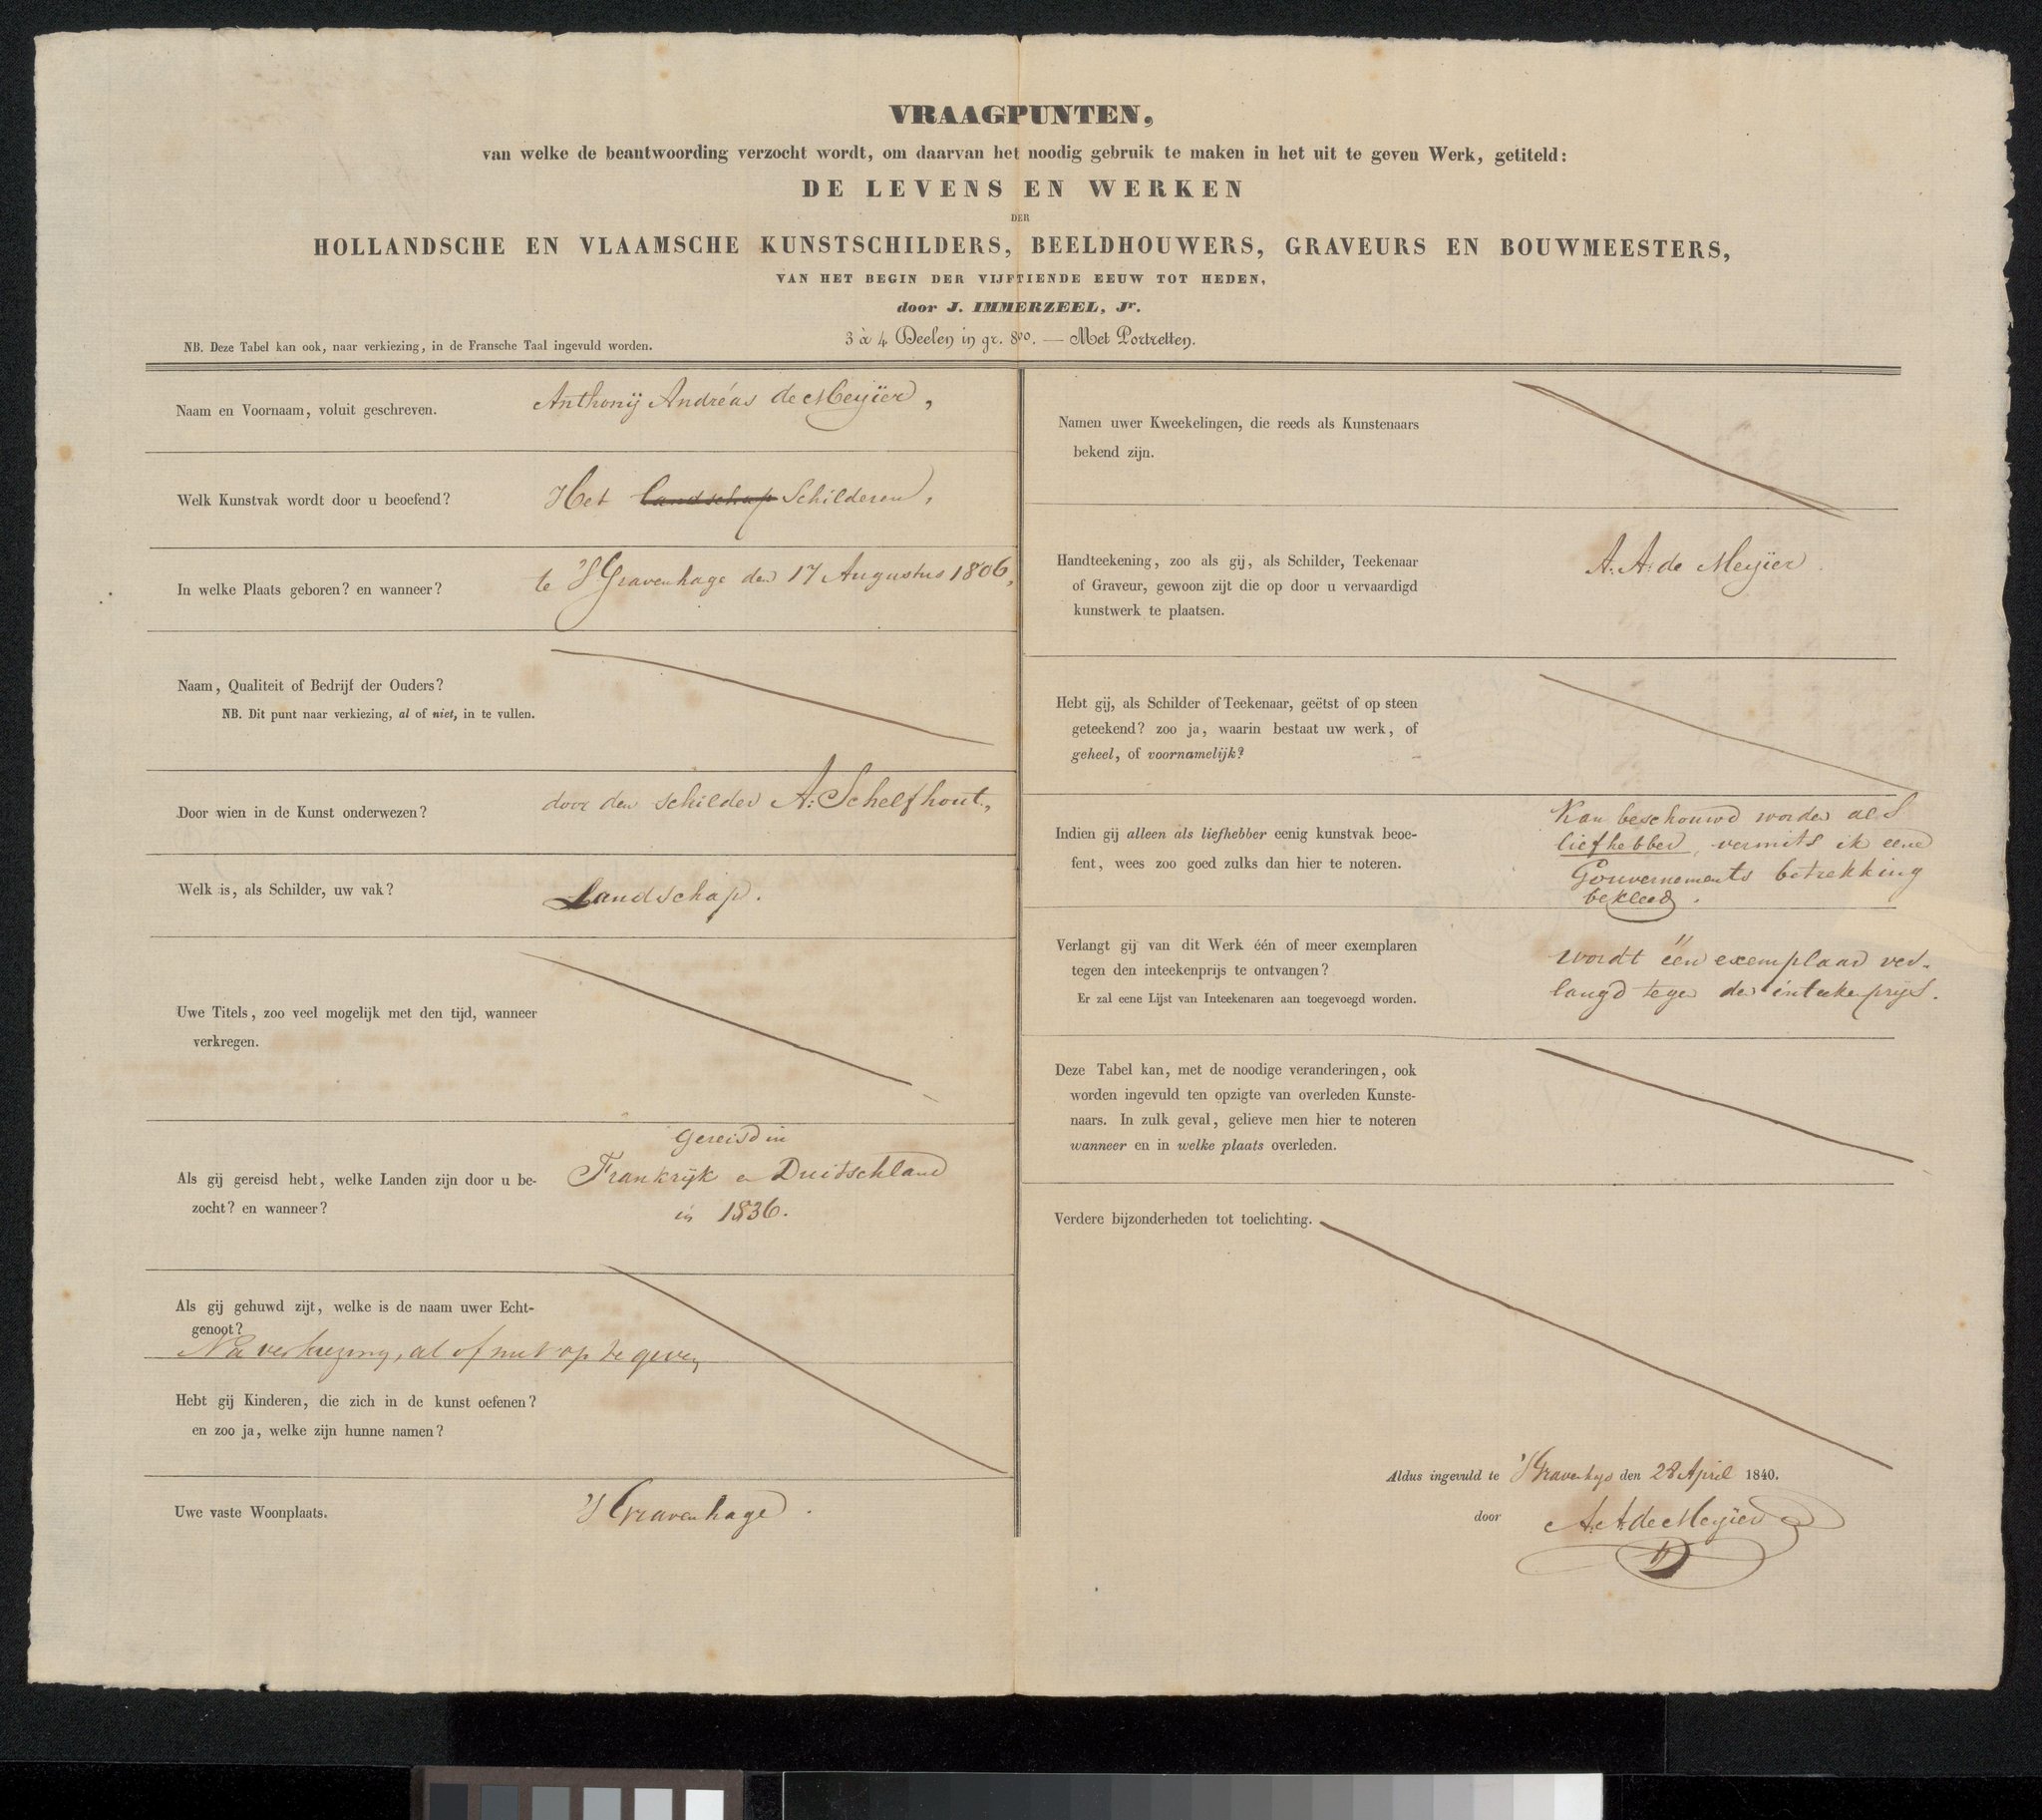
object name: manuscript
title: Enquêteformulier ingevuld door Anthony Andres de Meijier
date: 1840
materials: ink, paper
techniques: pen, printing, writing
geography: the hague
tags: anthony andreas meijier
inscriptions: inscription: ‘Vraagpunten,/ van welke de beantwoording verzocht wordt, om daarvan het noodig gebruik te maken in het uit te geven Werk, getiteld: De levens en werken/ der Hollandsche en Vlaamsche kunstschilders, beeldhouwers,/ graveurs en bouwmeesters, van het begin der vijftiende eeuw tot heden/ door J. Immerzeel, Jr.’, watermark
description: Opgenomen in: Immerzeel, J. Jr., De levens en werken der Hollandsche en Vlaamsche kunstschilders, beeldhouwers, graveurs en bouwmeesters, van het begin der vijftiende eeuw tot heden, Amsterdam: J.C. van Kesteren, 1842-1843.